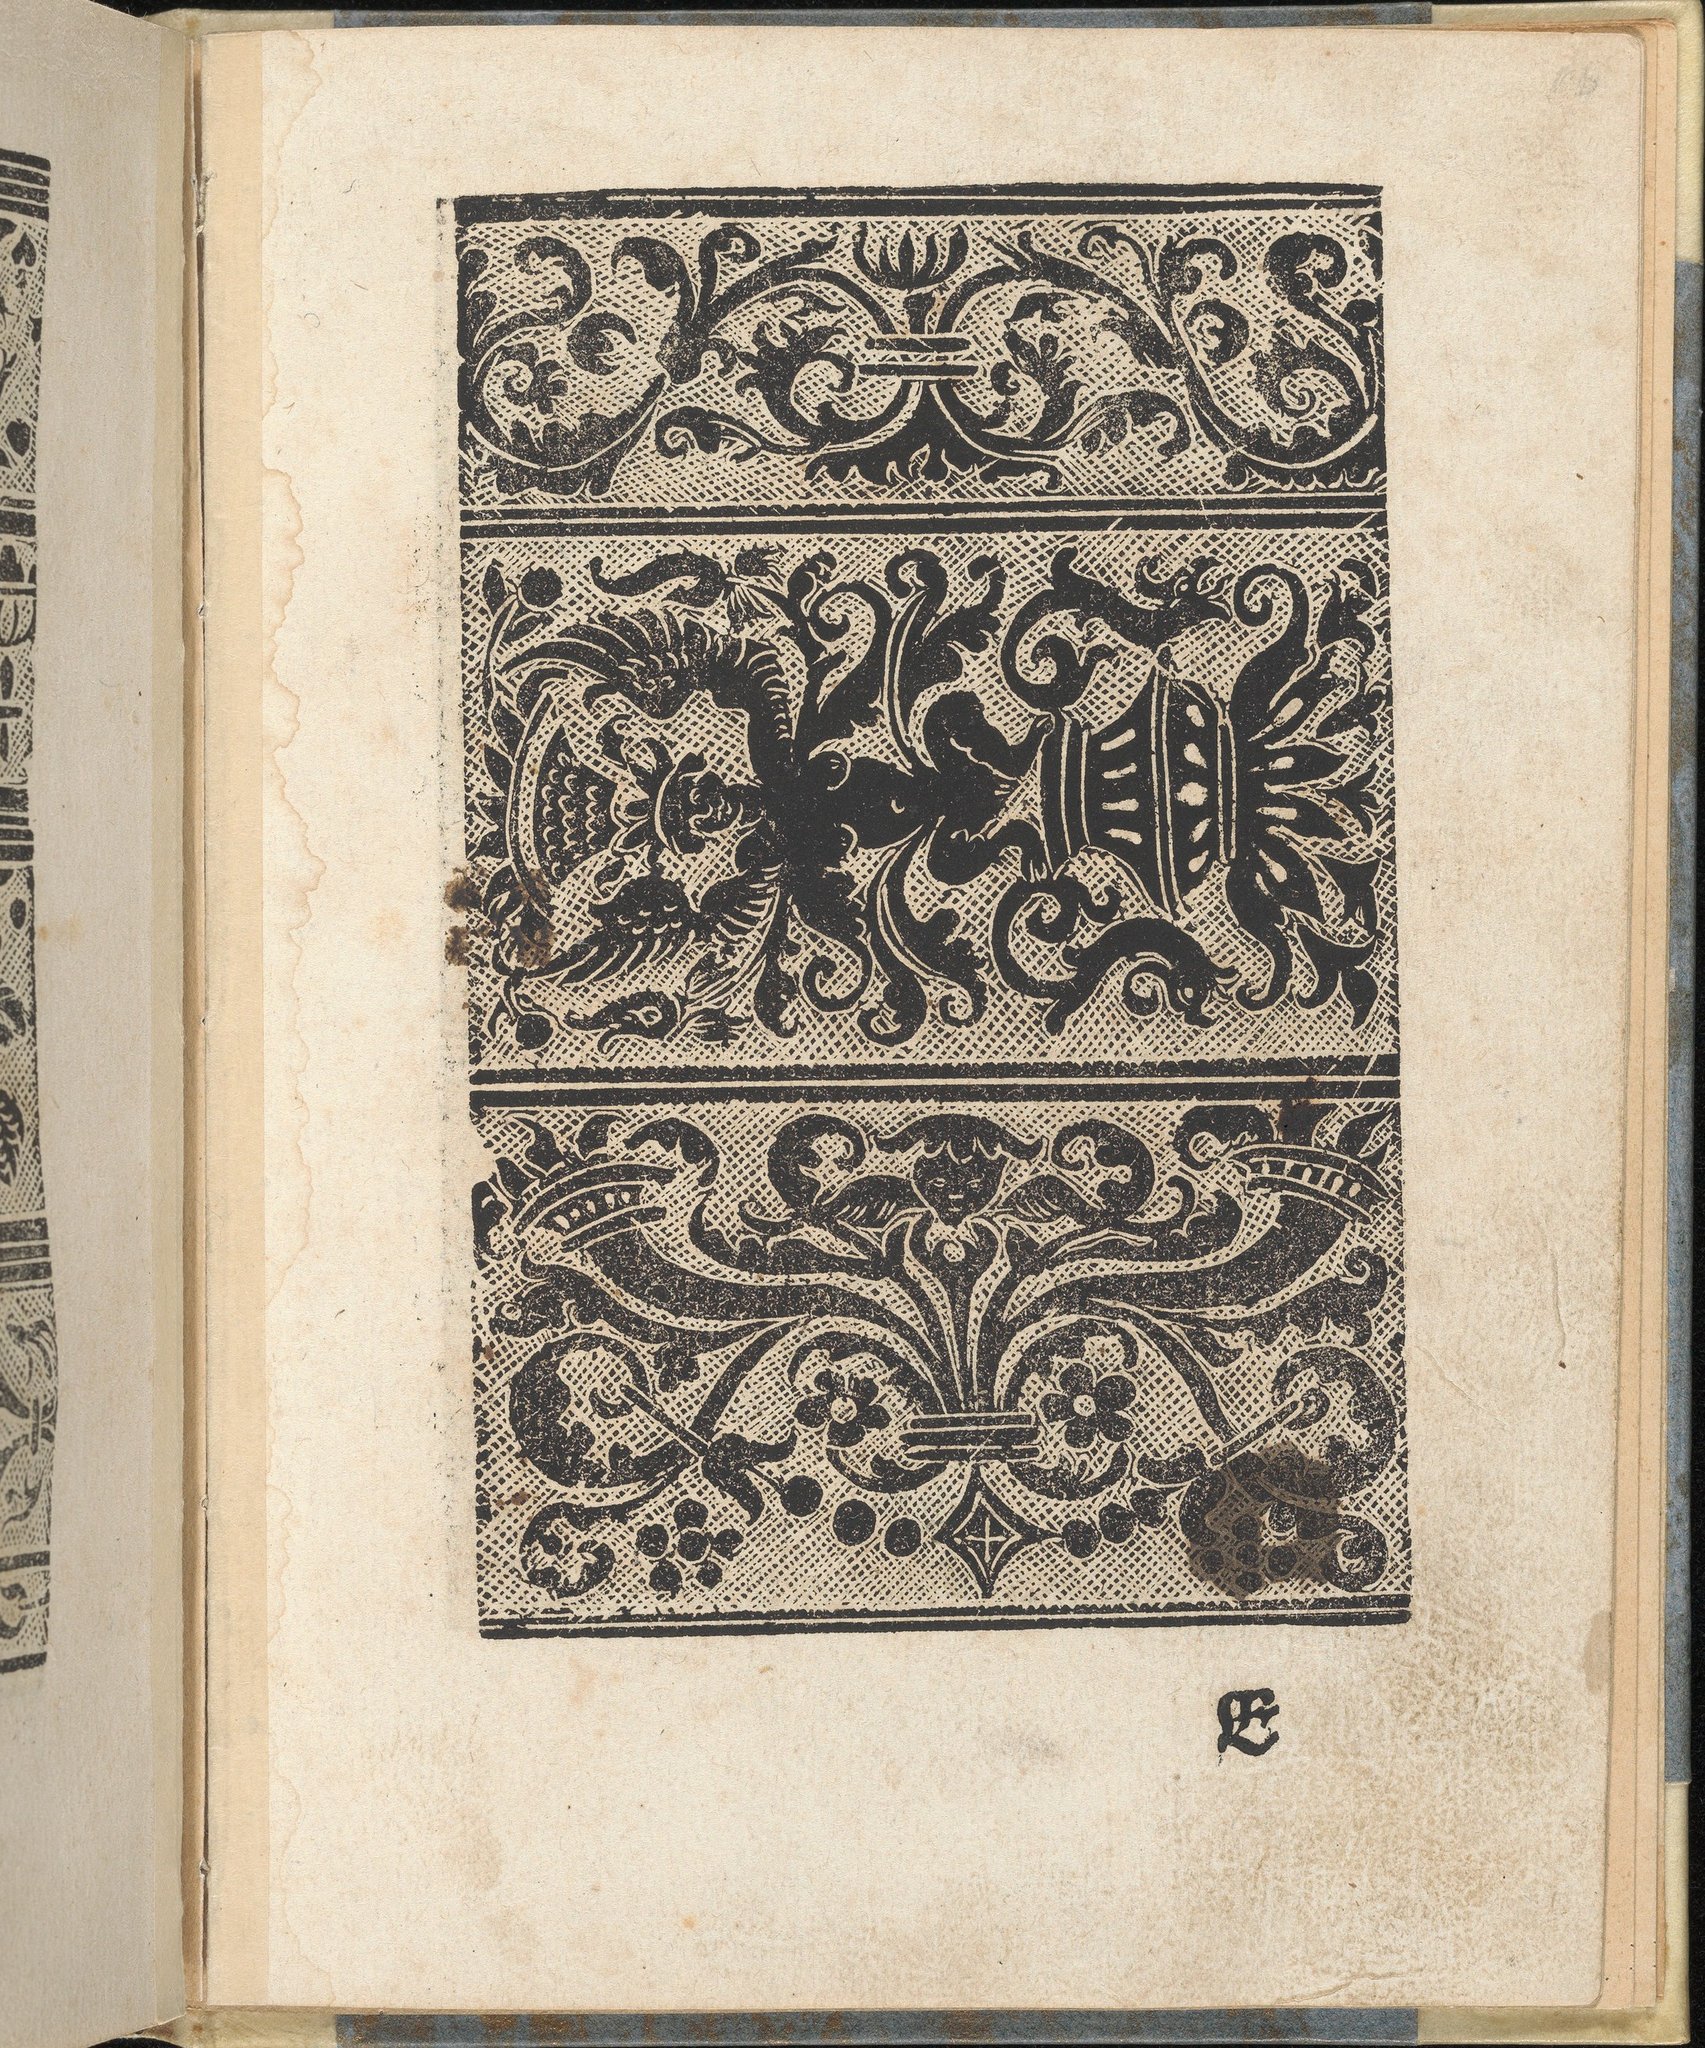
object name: book print ornament architecture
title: Ein ney Furmbüchlein, Page 15, recto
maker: johann schönsperger the younger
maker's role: publisher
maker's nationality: german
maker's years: 1490-1550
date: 1525-1529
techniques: woodcut